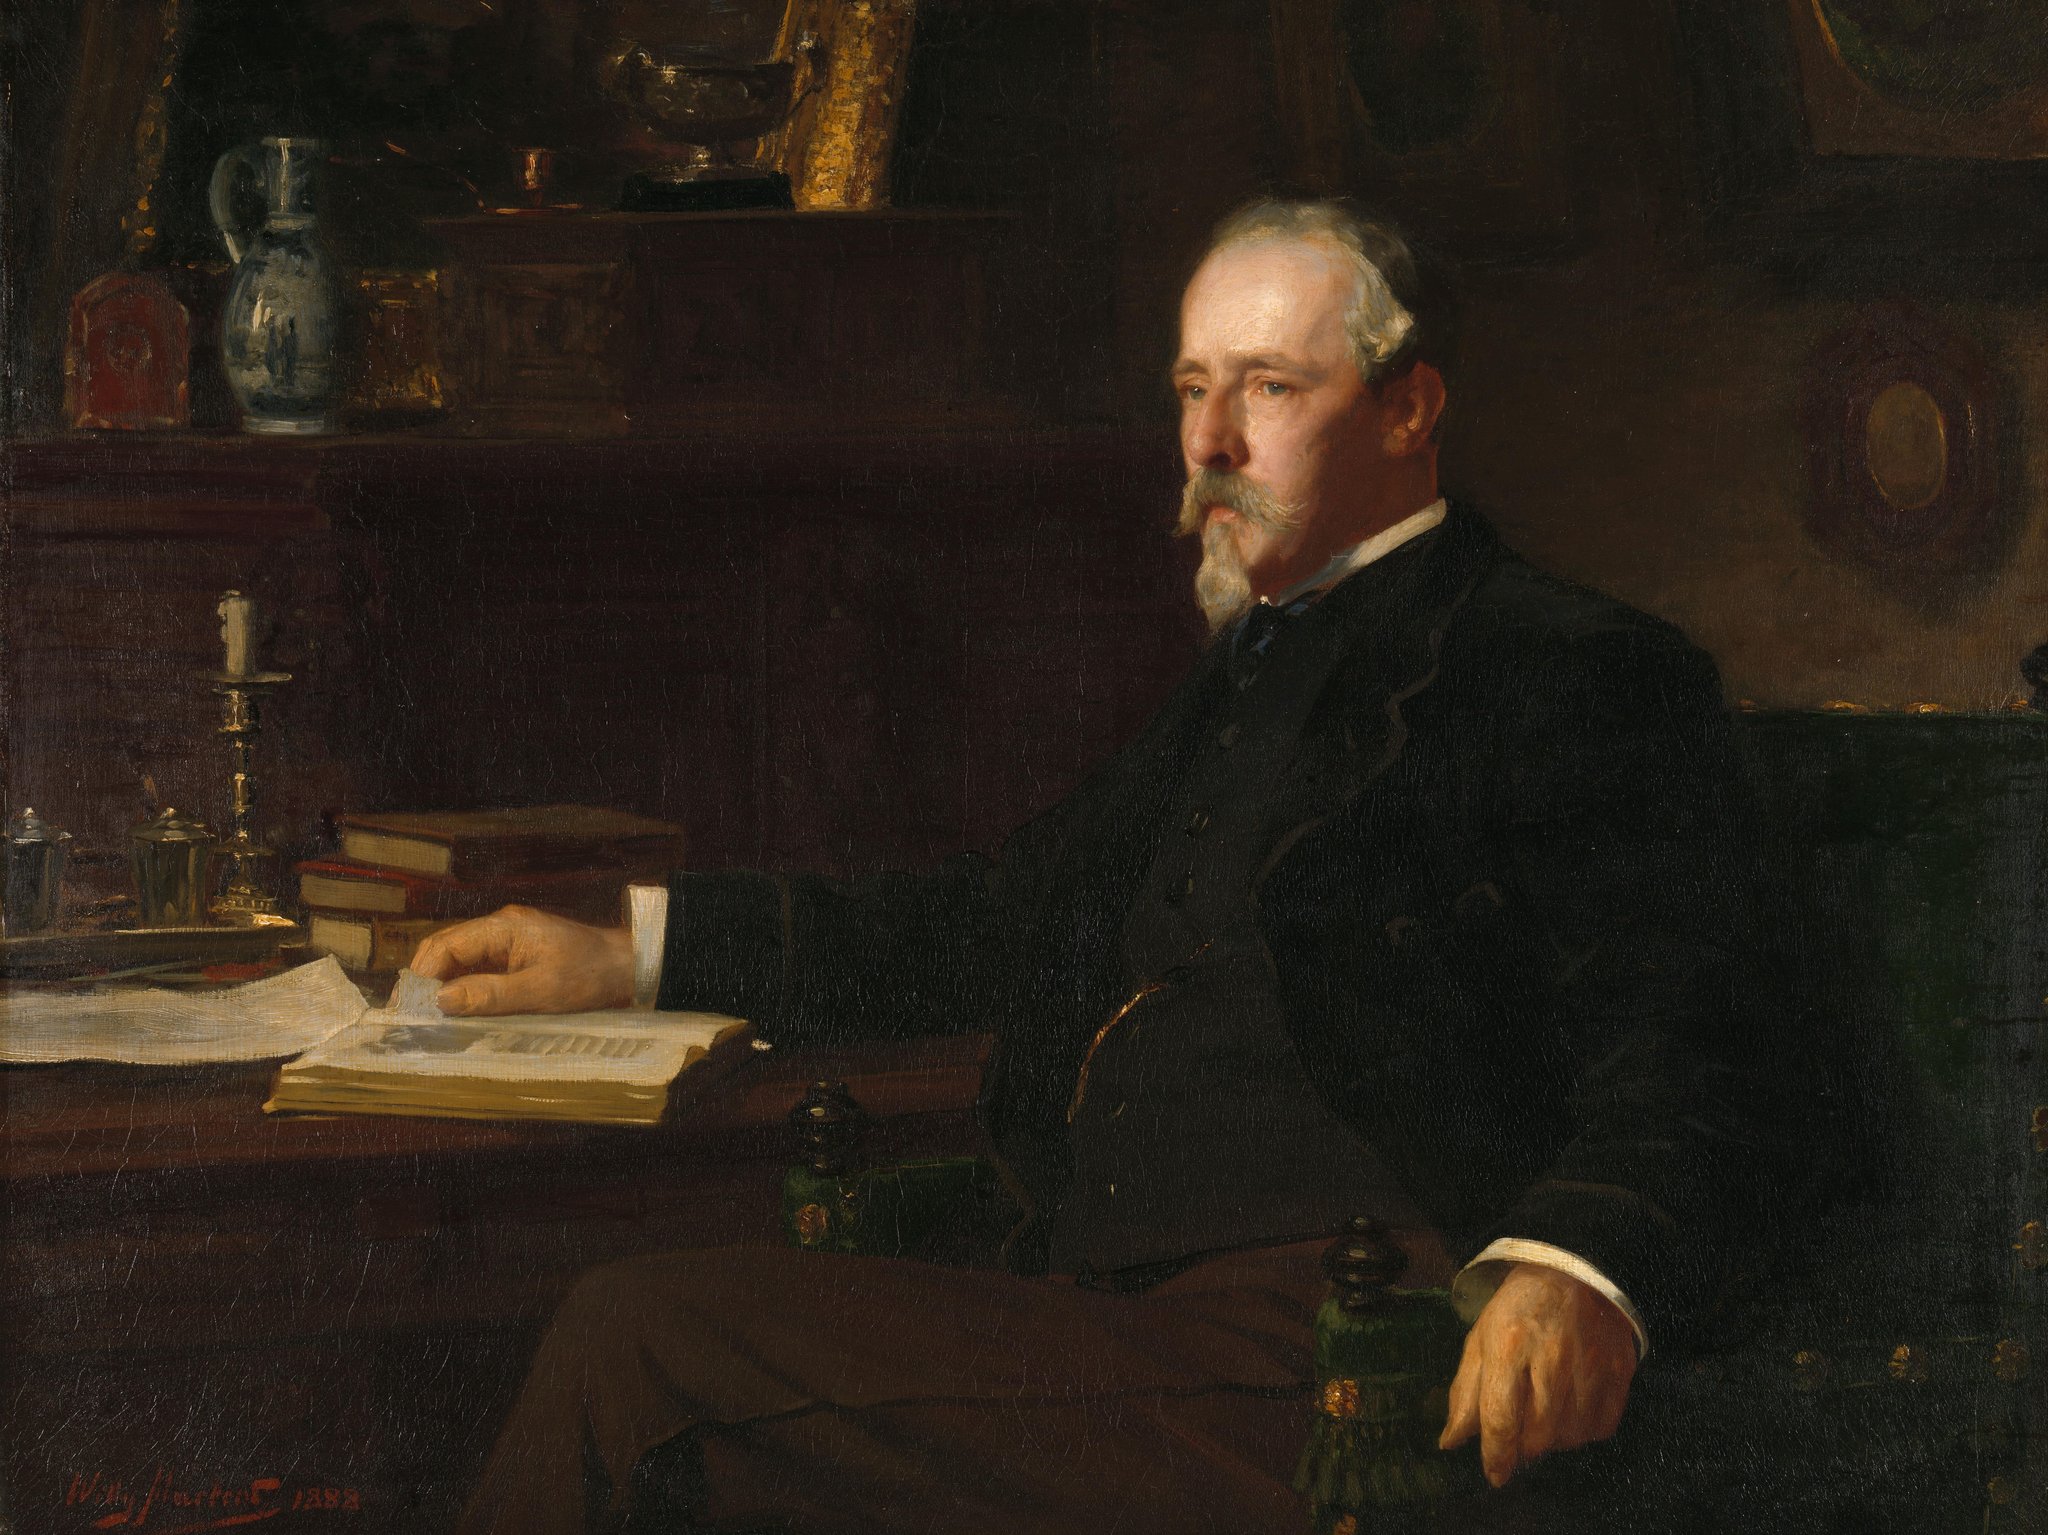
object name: painting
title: Daniël Franken Dzn (1838-98). Bankier en kunstverzamelaar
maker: willy martens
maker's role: painter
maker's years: 1856-1927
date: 1888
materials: canvas, oil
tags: daniël franken dzn., historical persons, person stimulating the arts; art lover, connoisseur, maecenas, patron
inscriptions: signature and date: ‘Willy Martens 1888’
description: Portret van Daniël Franken Dzn, bankier en kunstverzamelaar en oprichter van het Koninklijk Oudheidkundig Genootschap en de Vereniging Rembrandt. Kniestuk, zittend aan een bureau met zijn rechterhand op een opengeslagen boek voor zich. Op het bureau staan meer boeken, een inktstel en een kaars.